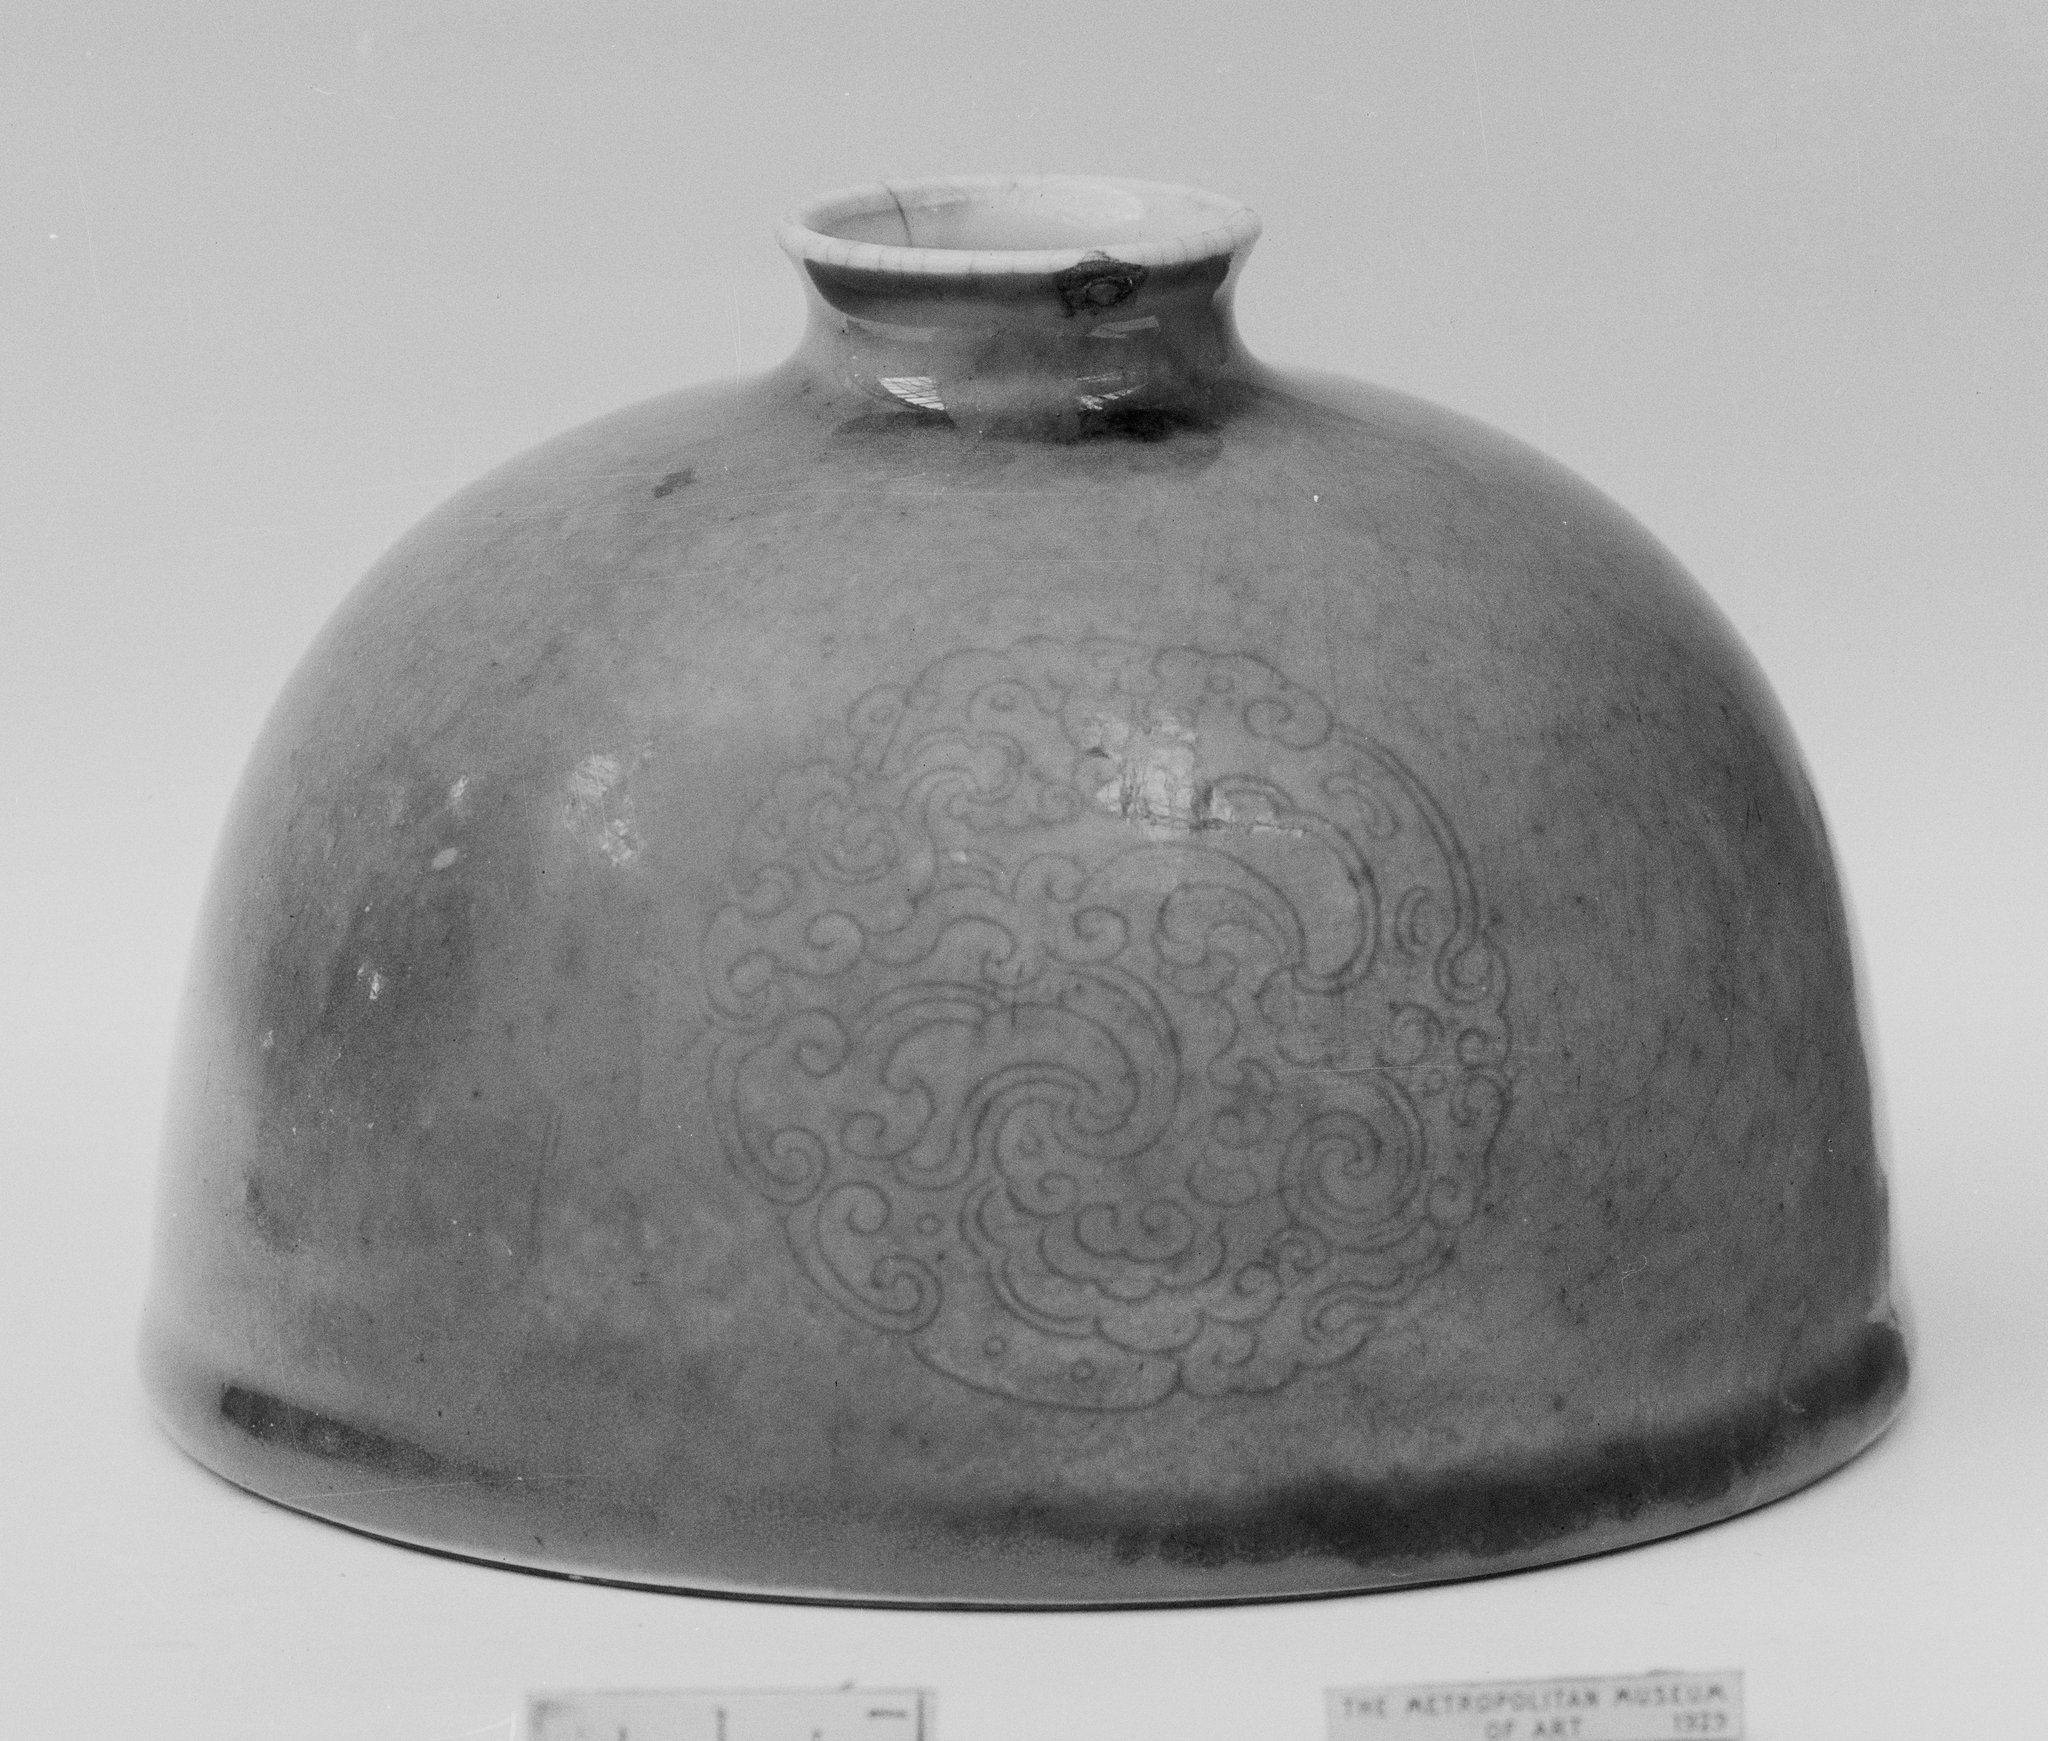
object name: water coupe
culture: chinese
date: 1662-1722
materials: glaze, porcelain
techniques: incising